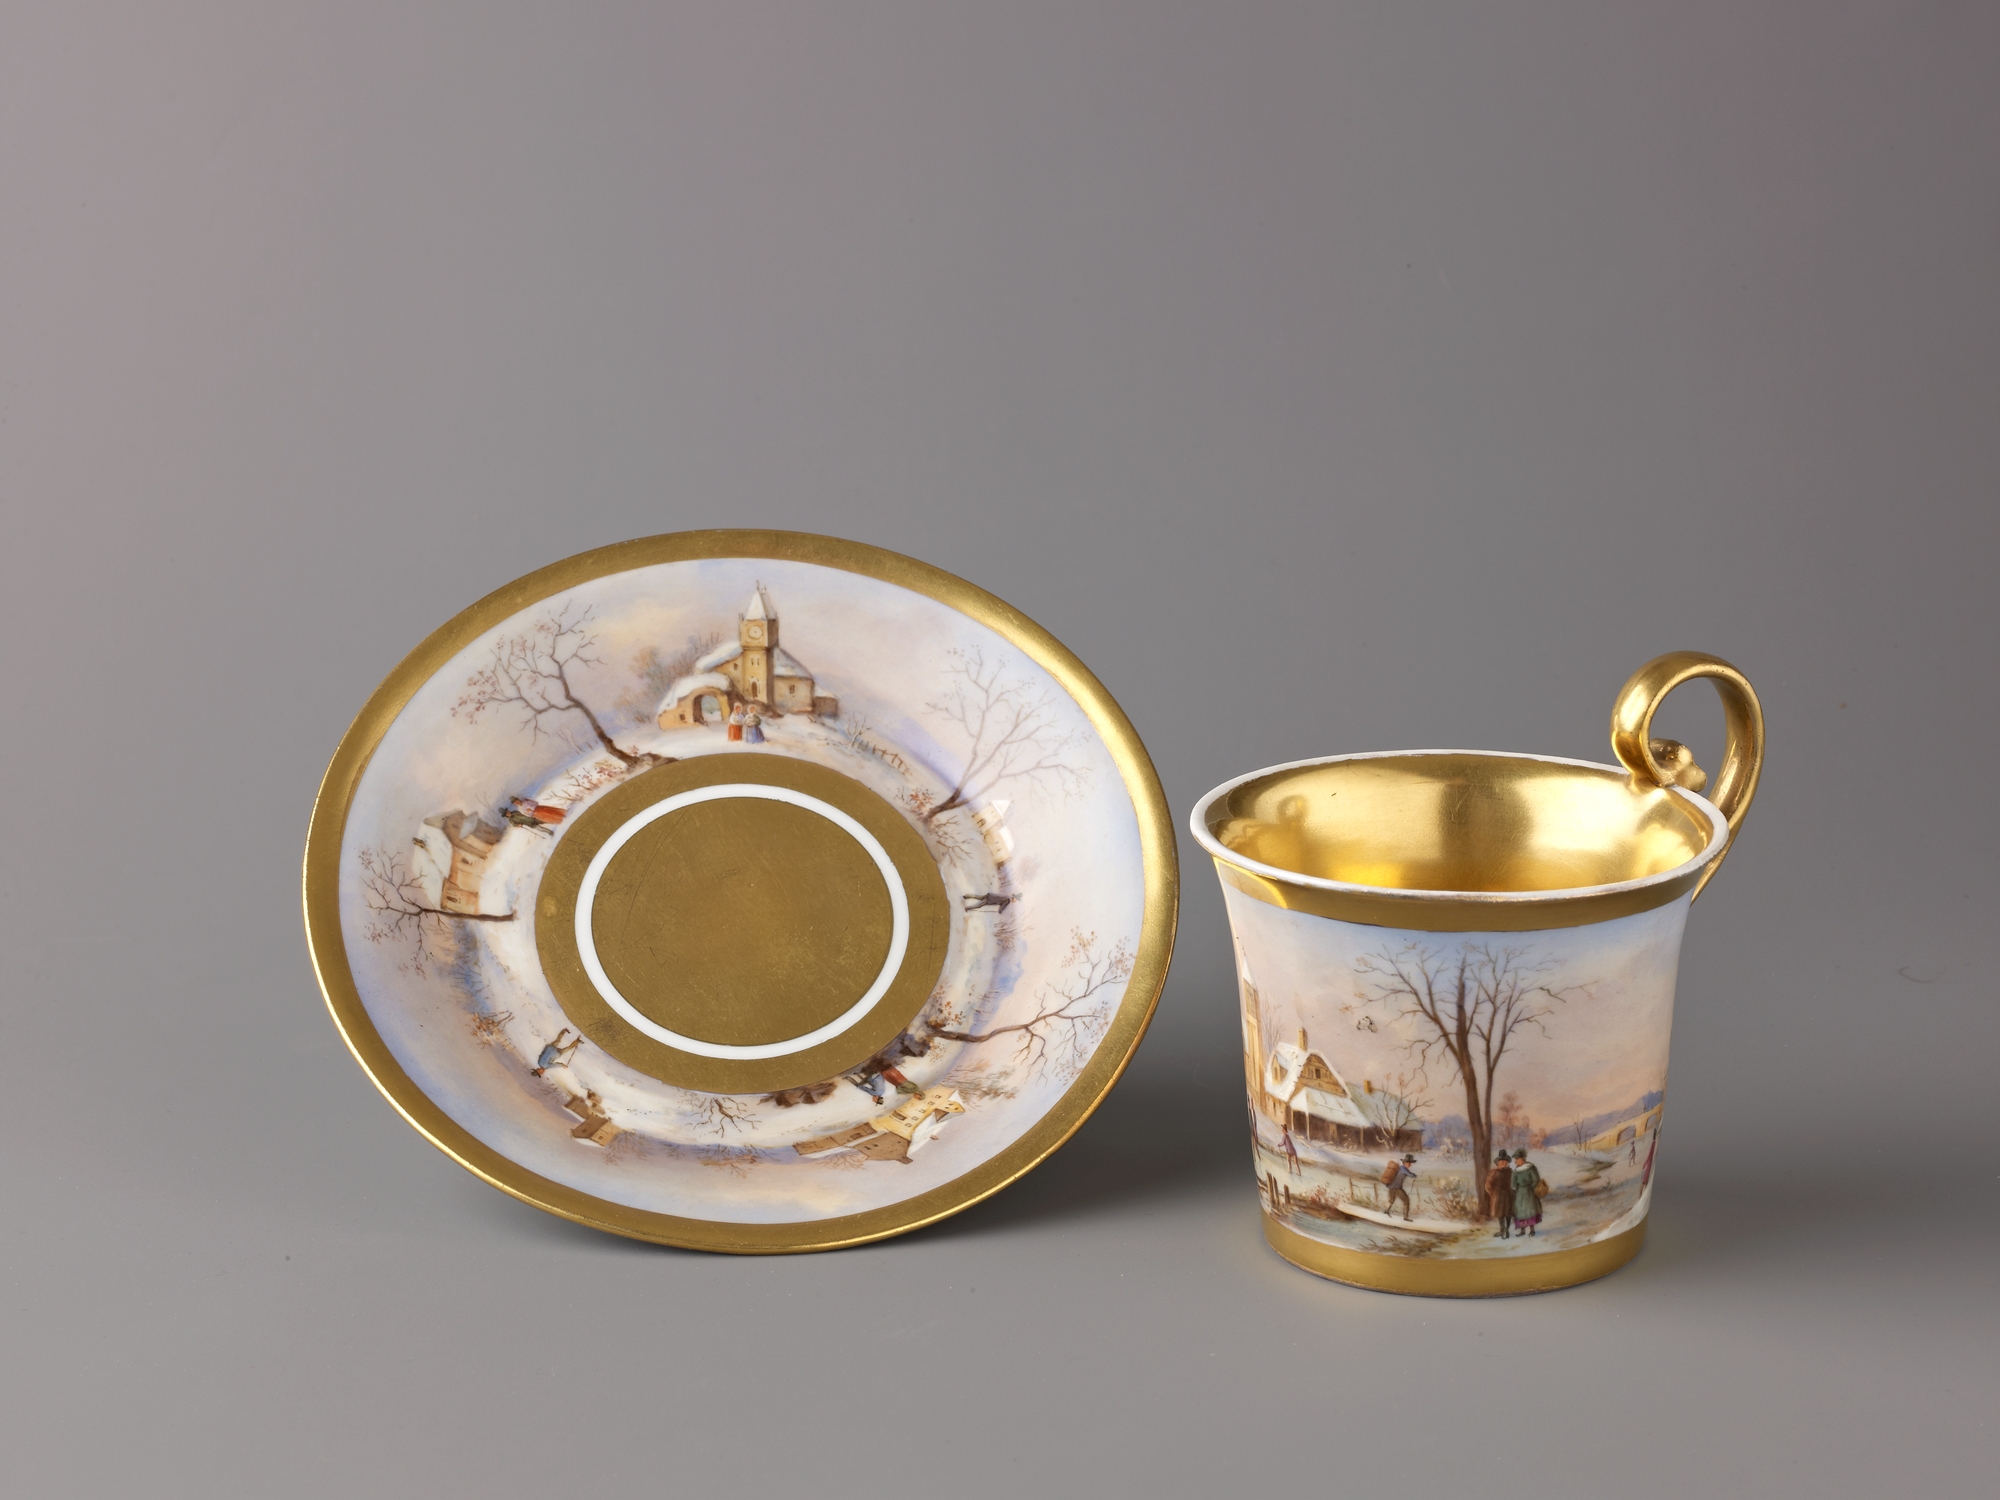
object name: cup and saucer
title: Cup and saucer with painted winter scenes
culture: austrian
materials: hard paste porcelain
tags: houses,winter,snow